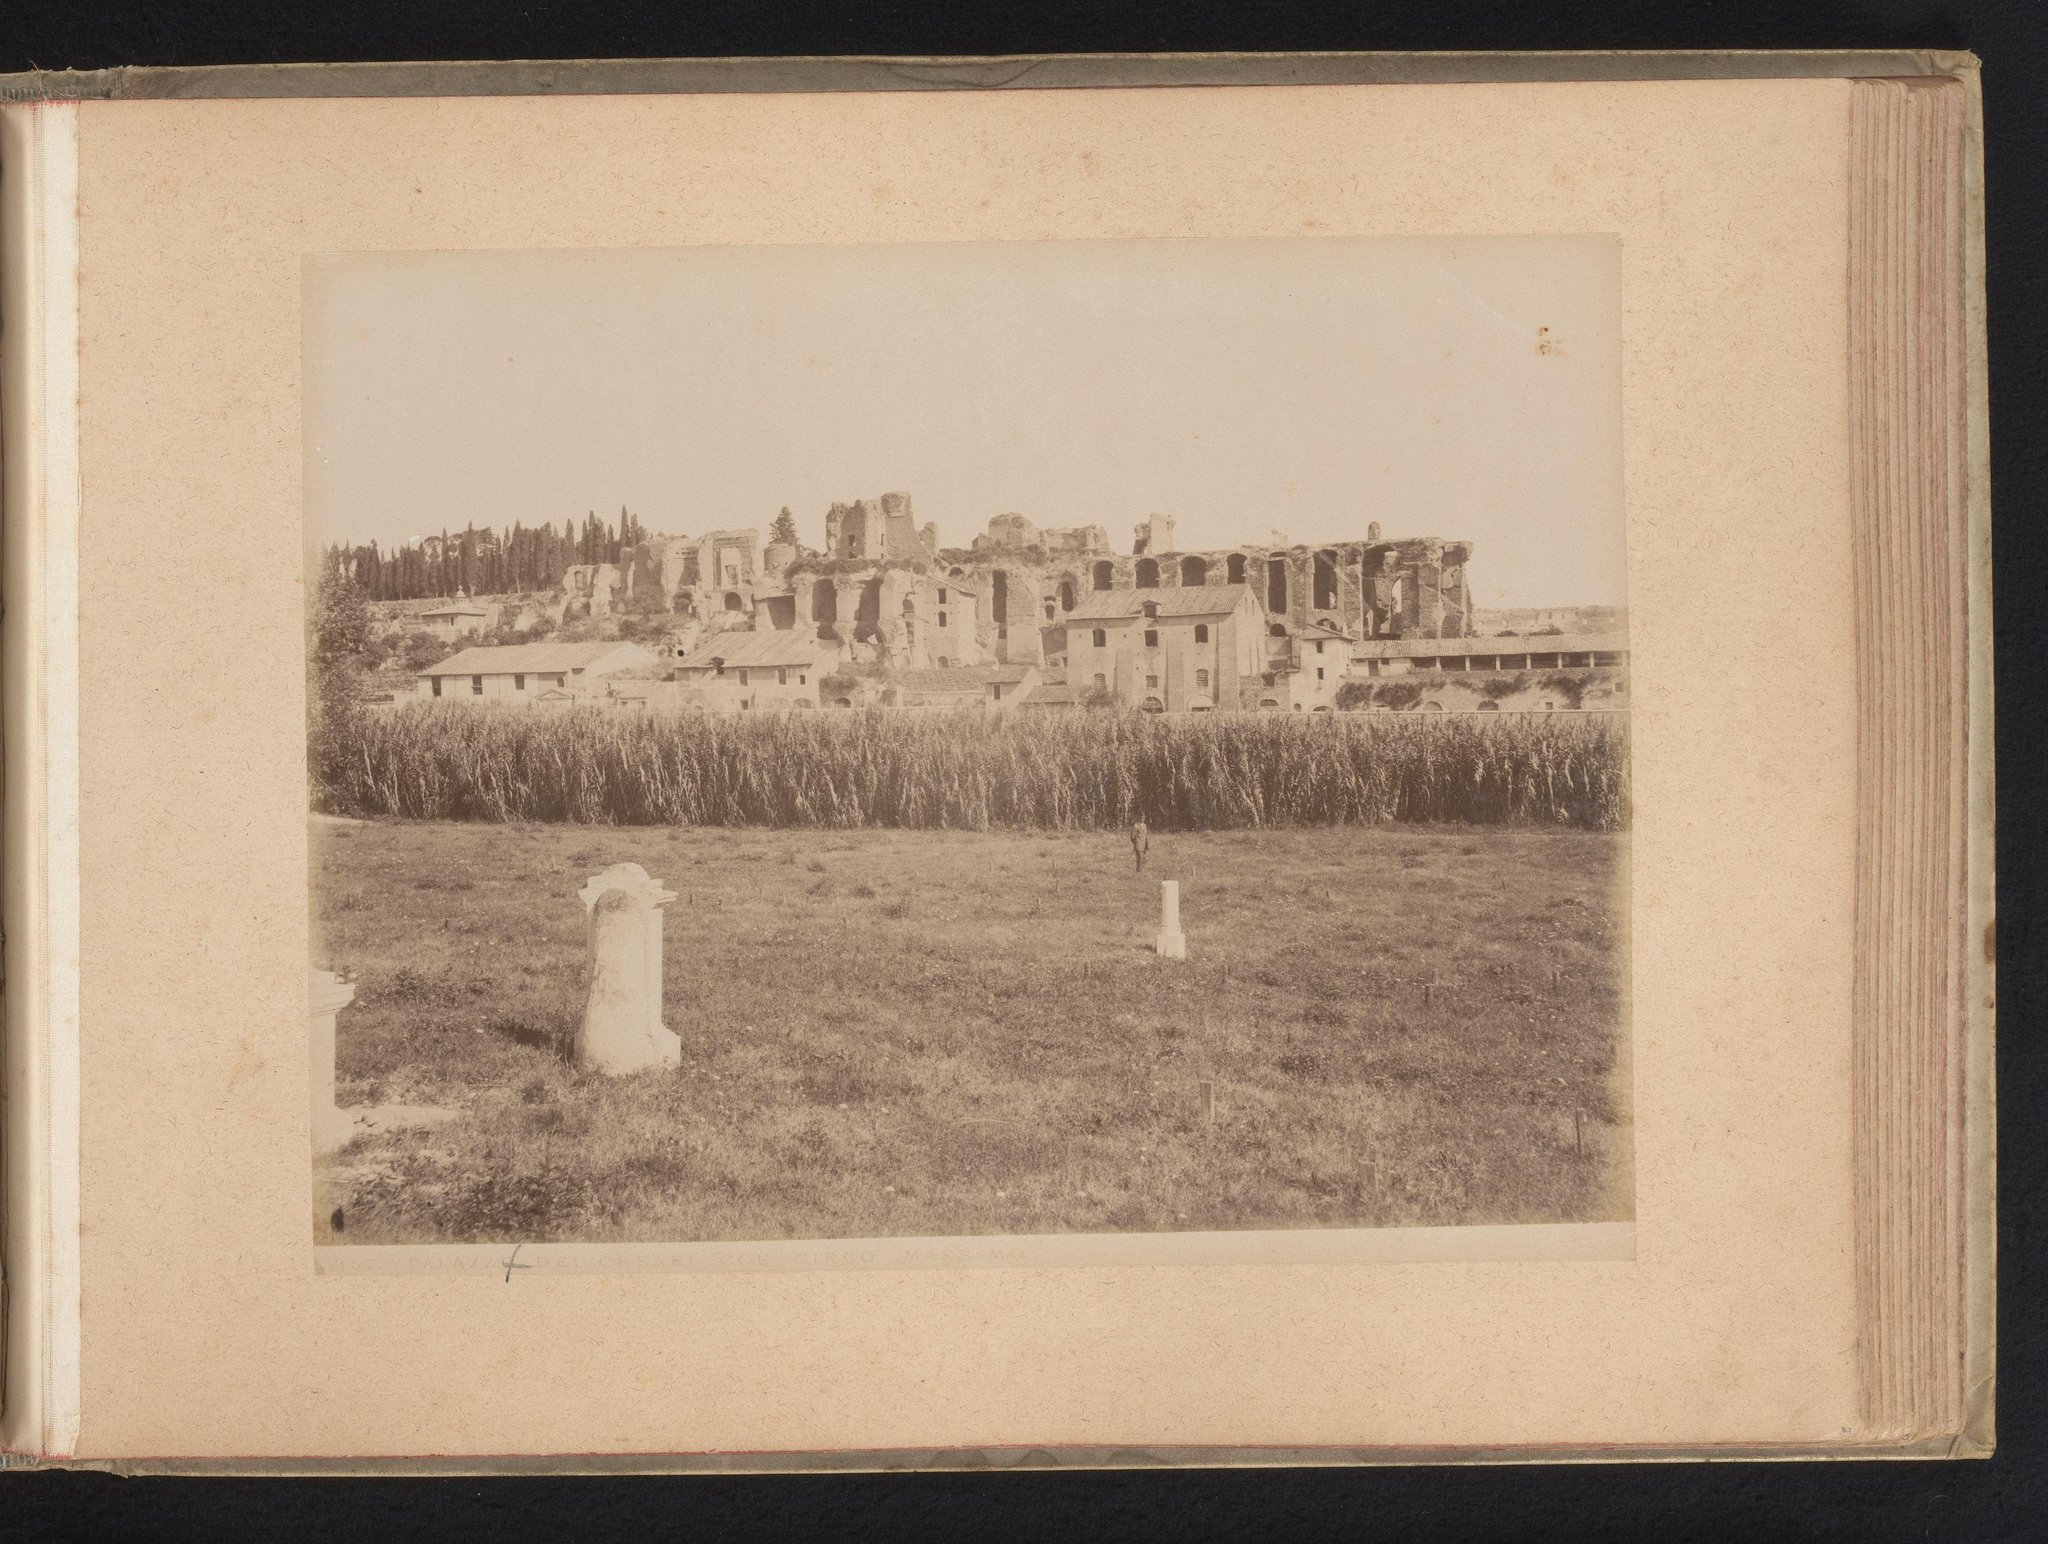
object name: album leaf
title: Gezicht op het Circus Maximus in Rome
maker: Anonymous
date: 1870-1895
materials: cardboard, photographic support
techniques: albumen print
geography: rome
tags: grounds, fields and accomodations for sports, games and physical performances (+ out of doors (sports, games, etc.)), prospect of city, town panorama, silhouette of city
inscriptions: inscription: ‘PALLAZO DEL CESARI COL CIRCO MASSIMO’